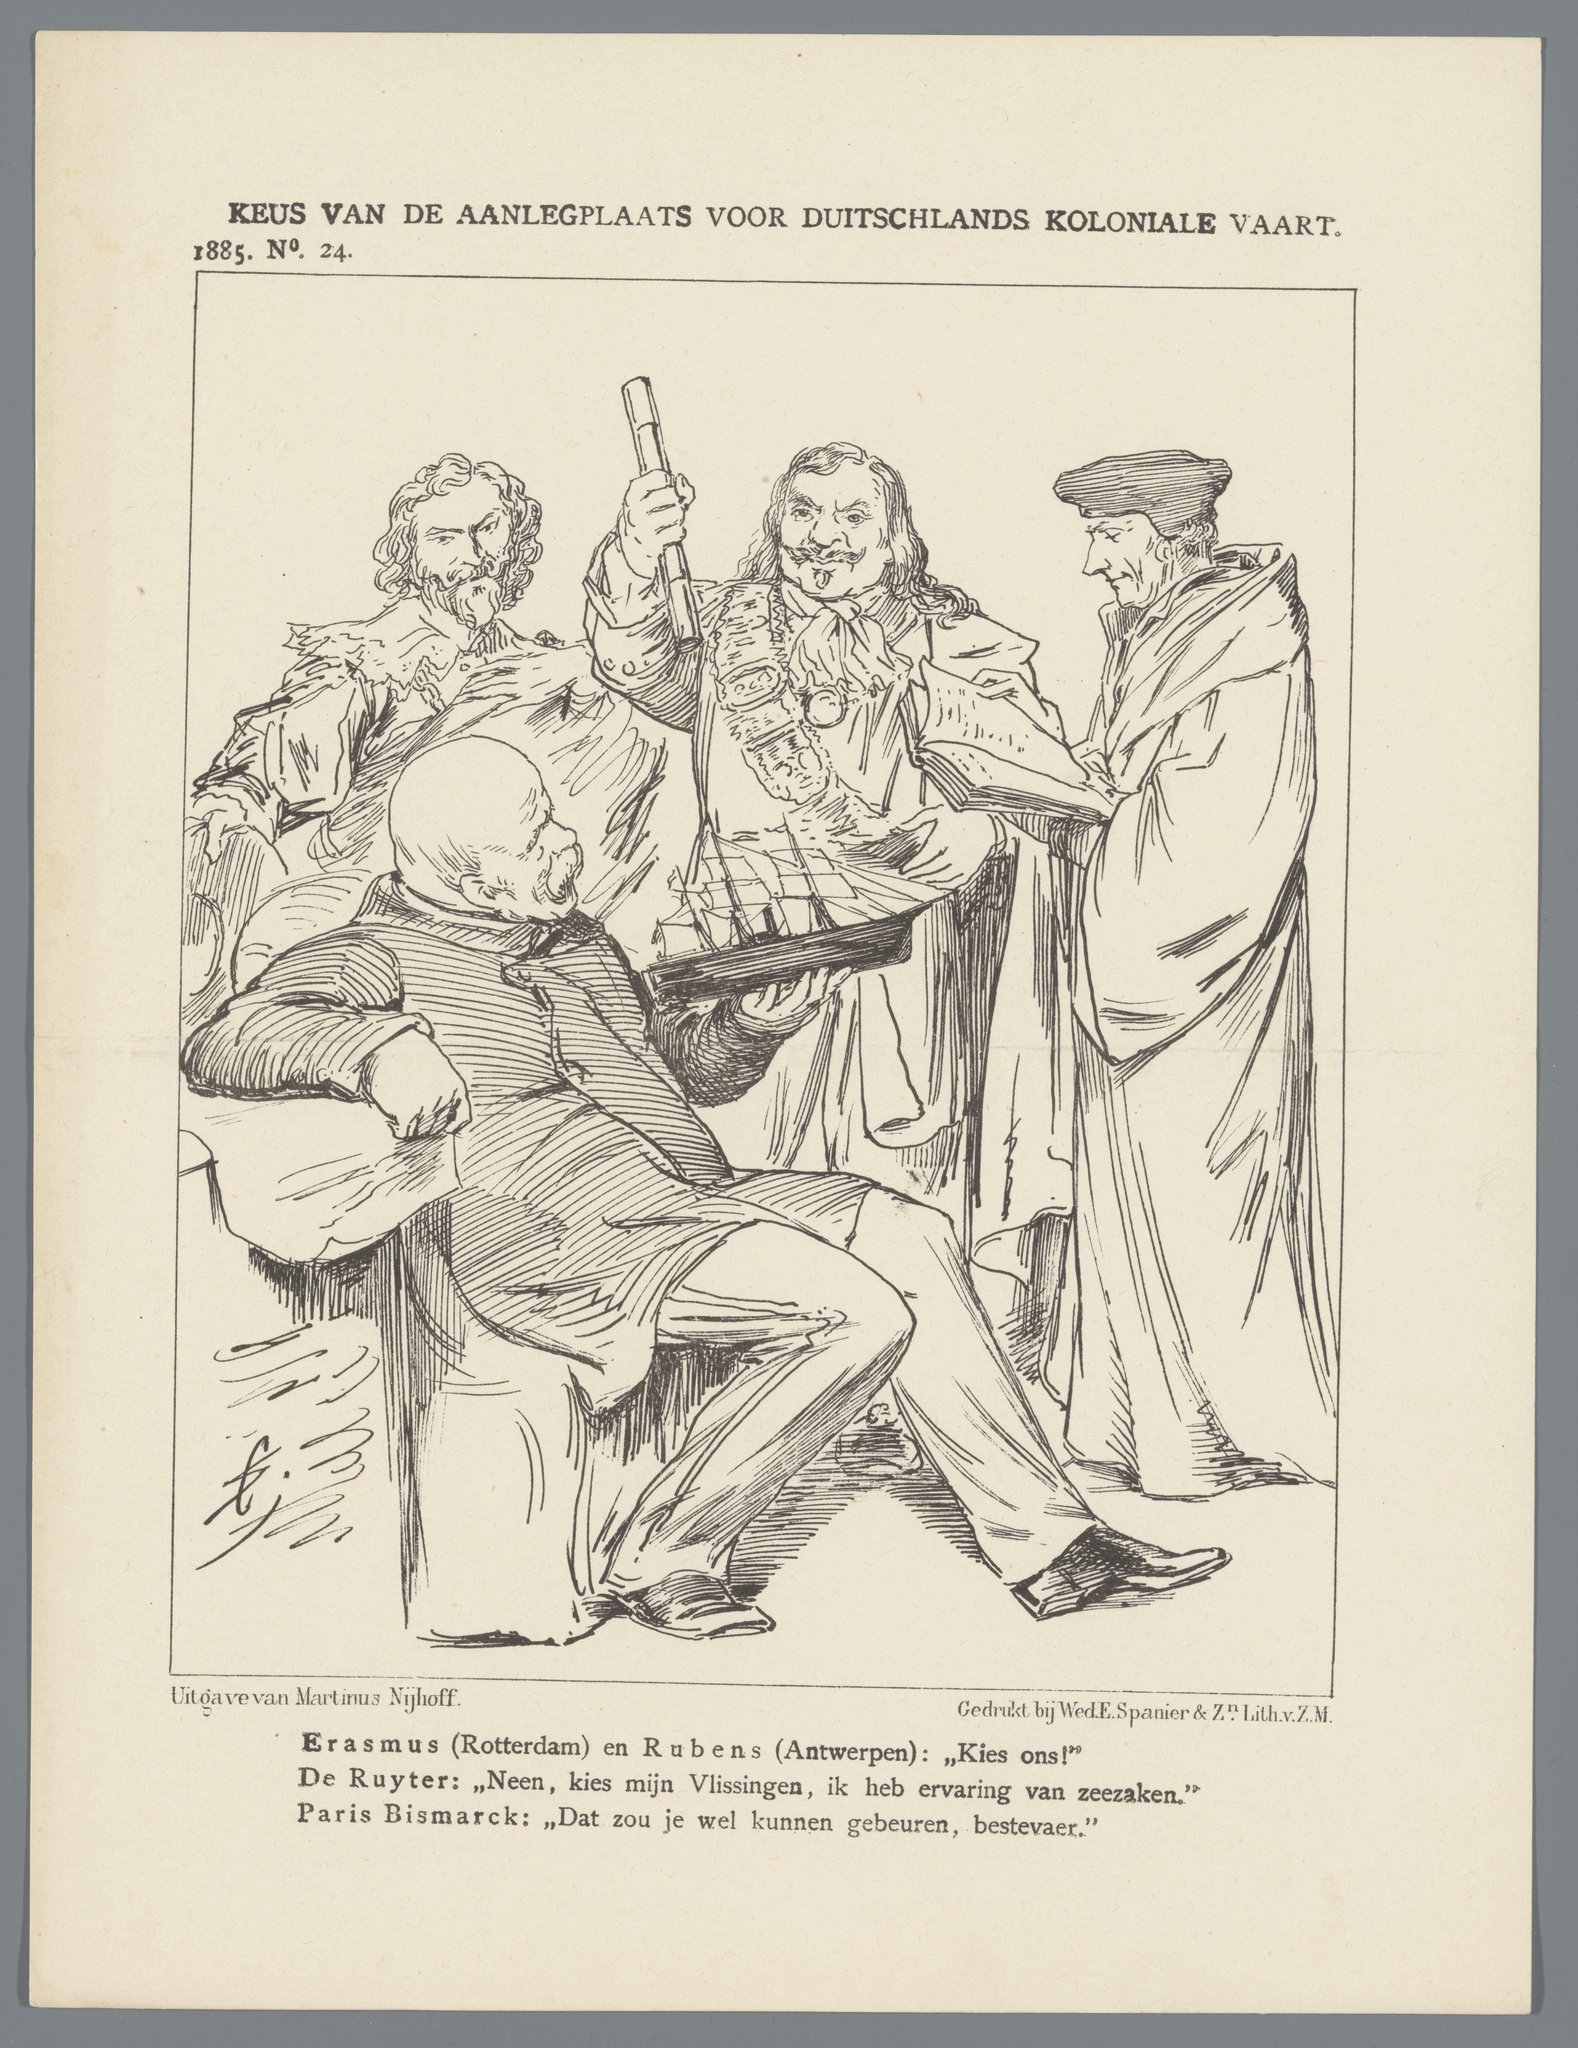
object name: print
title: Keus van de aanlegplaats voor Duitschlands koloniale vaart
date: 1885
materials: paper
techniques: lithograph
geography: netherlands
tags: desiderius erasmus, flushing, michiel adriaenszoon de ruyter, antwerp, painter, print maker, draughtsman, peter paul rubens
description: Spotprent met Bismarck, De Ruyter, Rubens en Erasmus. Over de keuze van een haven voor de Duitse koloniale vaart. Plaat verschenen bij het weekblad De Nederlandsche Spectator, nr. 24, 1885.